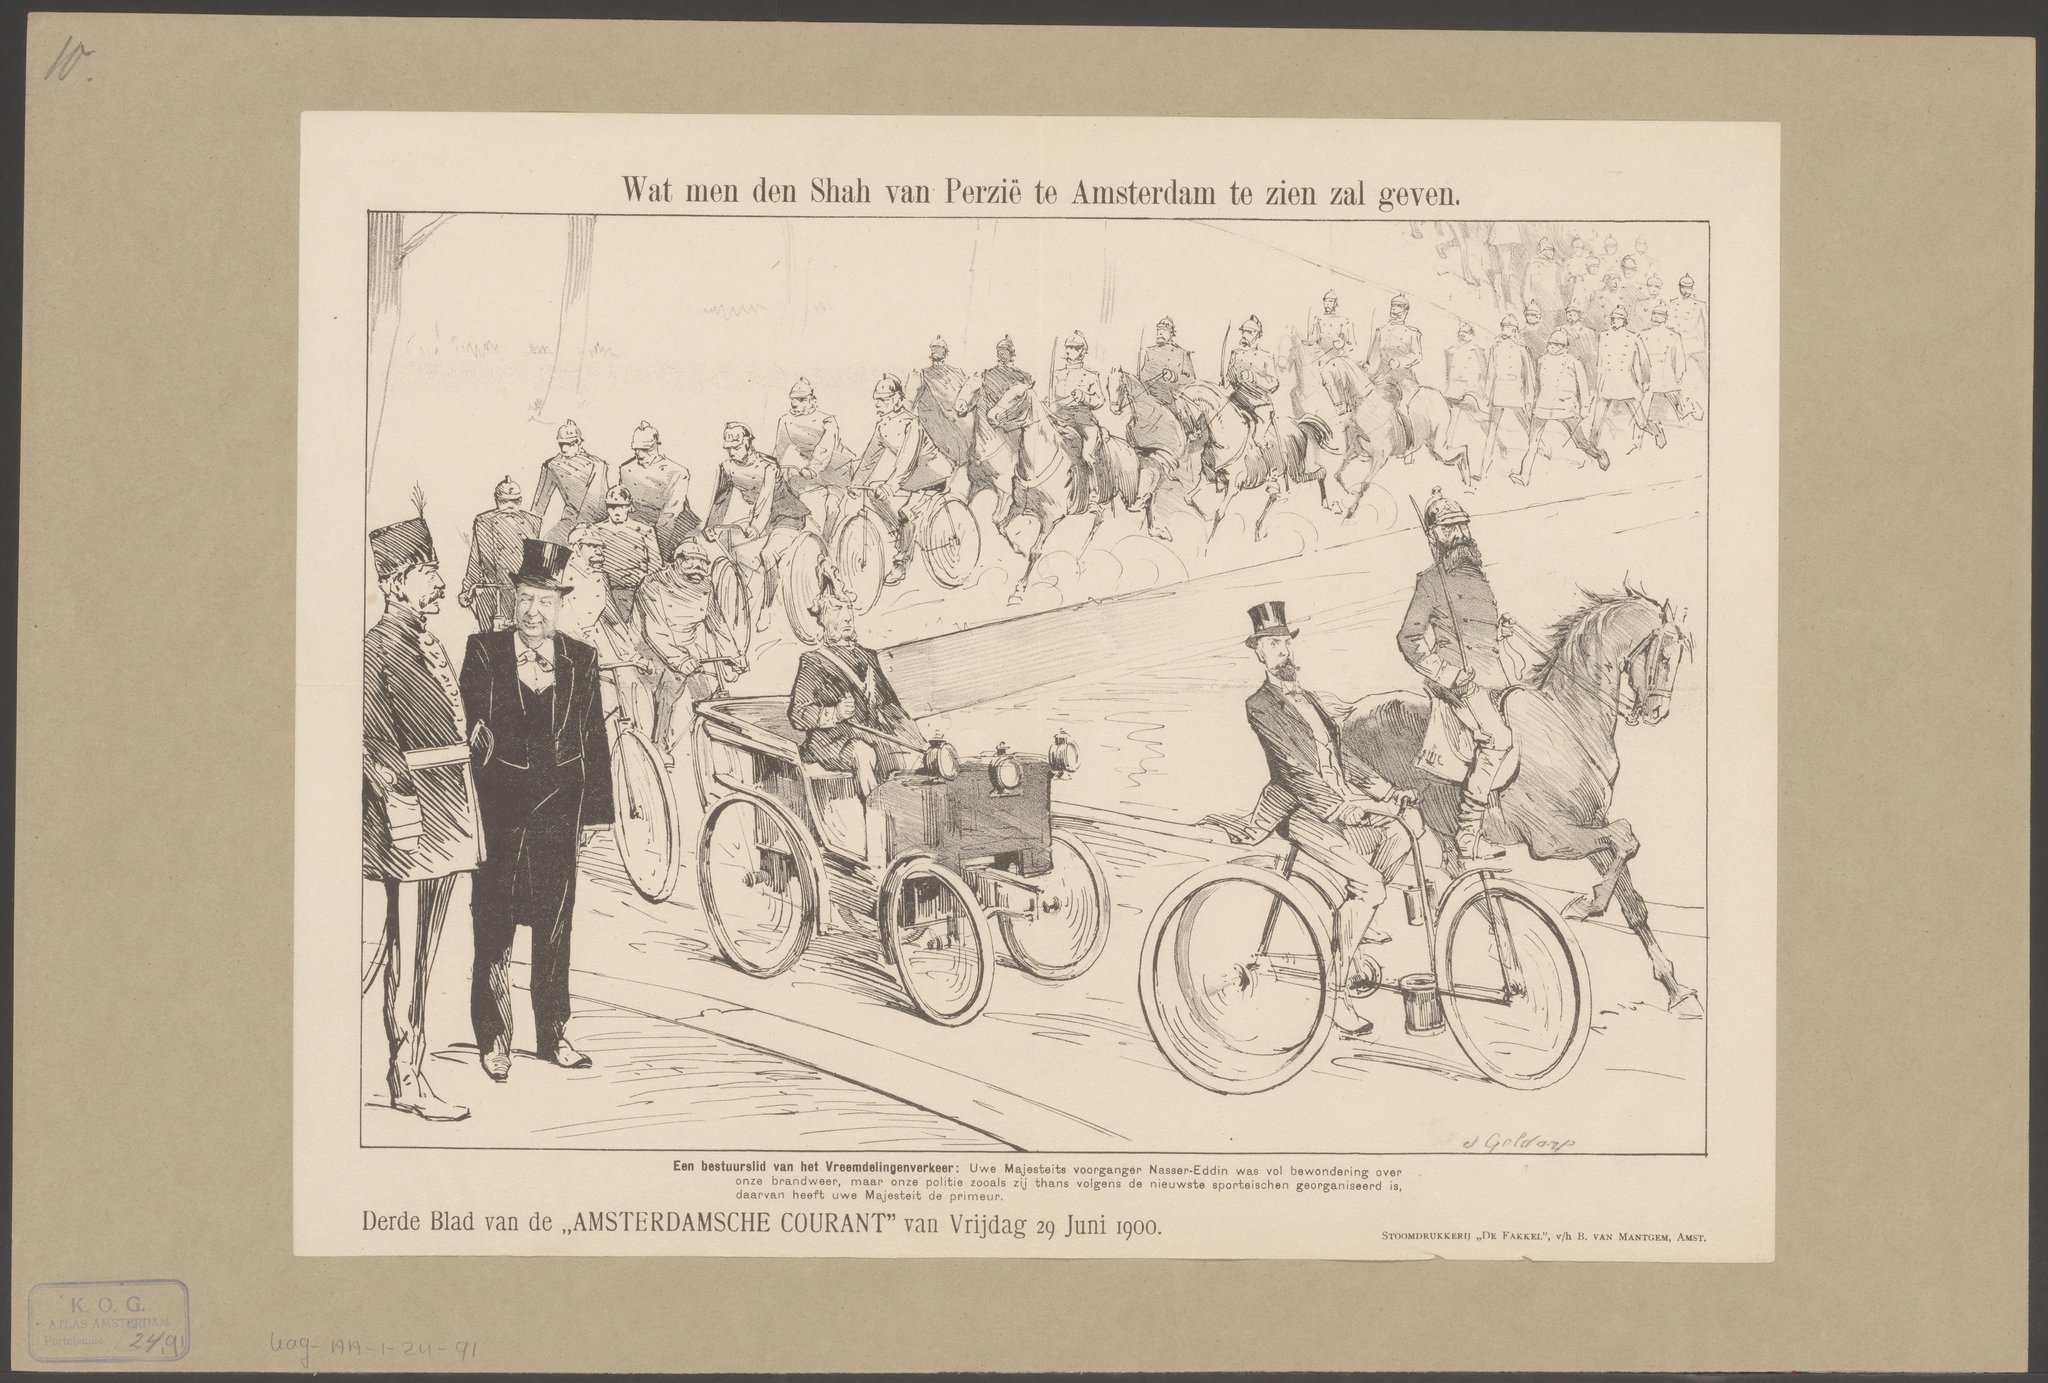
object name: cartoon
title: Wat men den shah van Perzië te Amsterdam te zien zal geven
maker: petrus van geldorp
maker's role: draughtsman, print maker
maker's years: 1872-1939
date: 1900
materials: paper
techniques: letterpress printing, lithograph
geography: netherlands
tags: politician, tricycle, (military) tattoo, bicycle, horse, automobile, police, amsterdam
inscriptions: collector's mark: Lugt 1641b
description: Gepubliceerd als bijvoegsel van 'De Amsterdamsche Courant', 29 juni 1900.